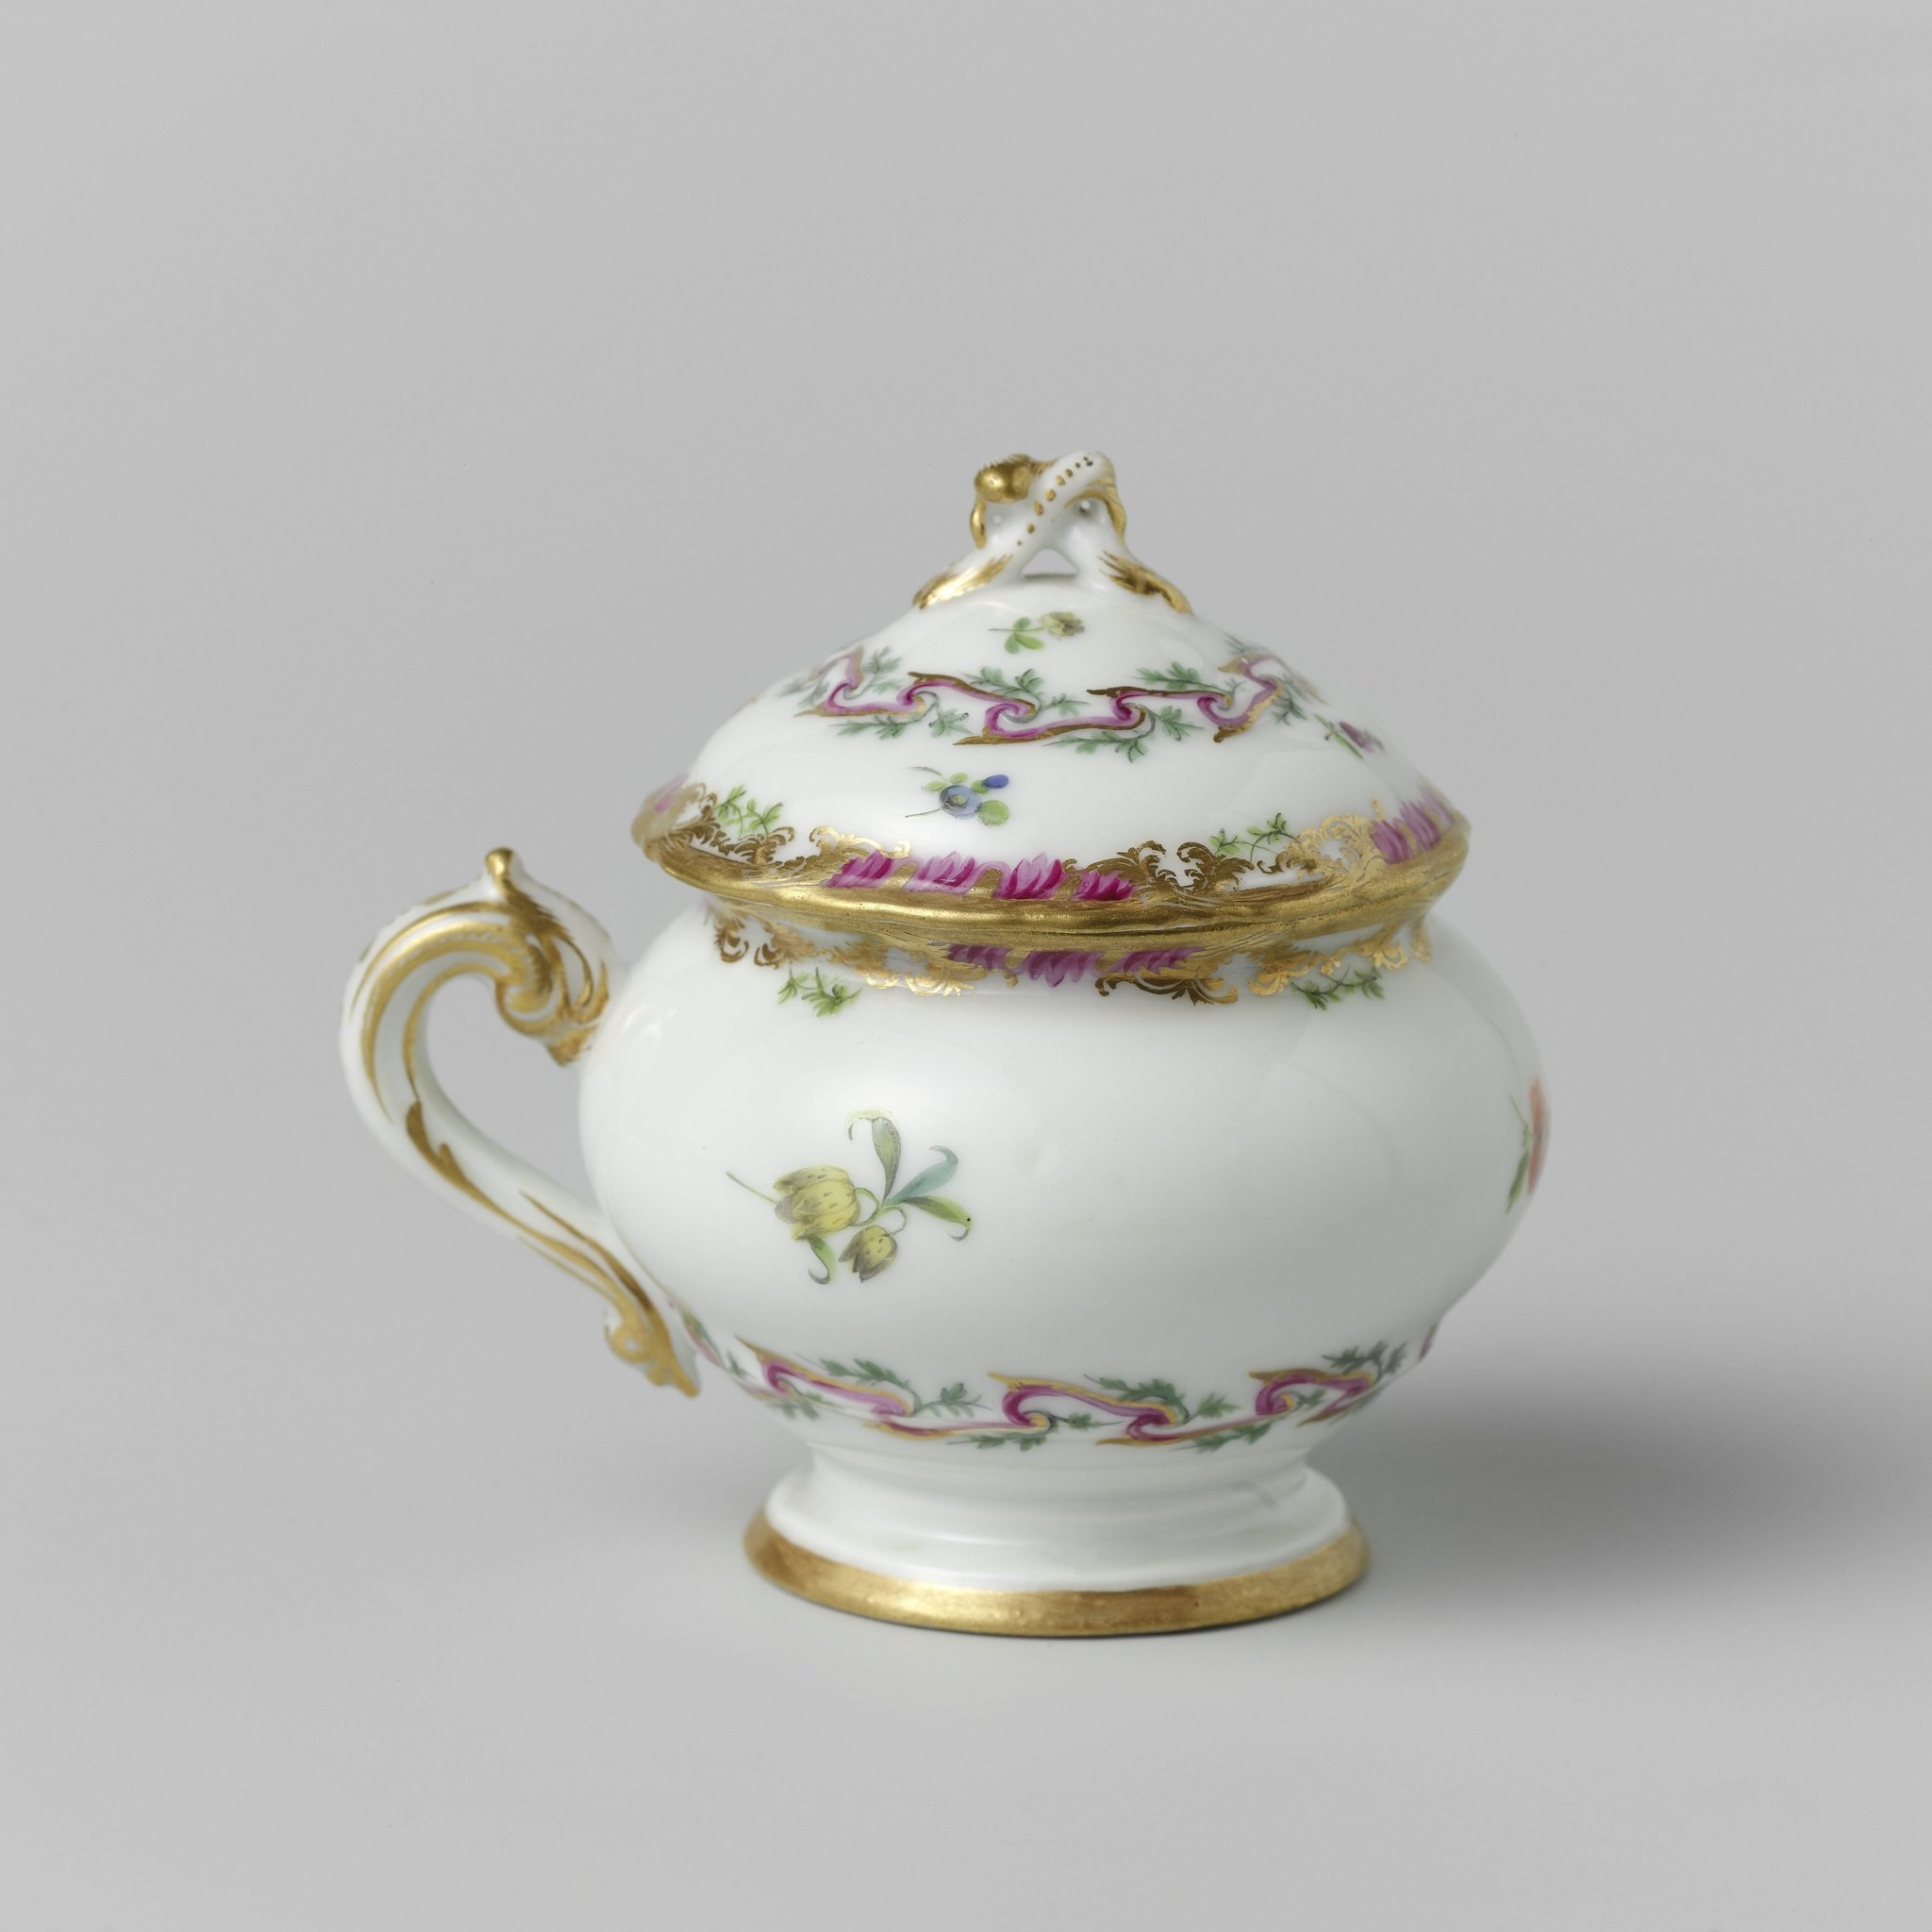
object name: pasteipot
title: Pasteipot,rond,met deksel en oor, behorend bij een servies met geslingerd lintmotief met bladertakken, bloemboeketten en gestrooide bloemtakken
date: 1780-1820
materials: porcelain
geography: loosdrecht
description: Pasteipot, rond, met deksel en oor, behorend bij een servies van porselein met geslingerd motief in paars en goud met groene bladertakken, bloemboeketten en gestrooide bloemtakken. Randen lichtgegolfd met decoratie in goud met paars bladmotief waartussen groen gekruist bladmotief. Gemerkt: M.O.L. en AMSTEL. Serie van elf stuks.